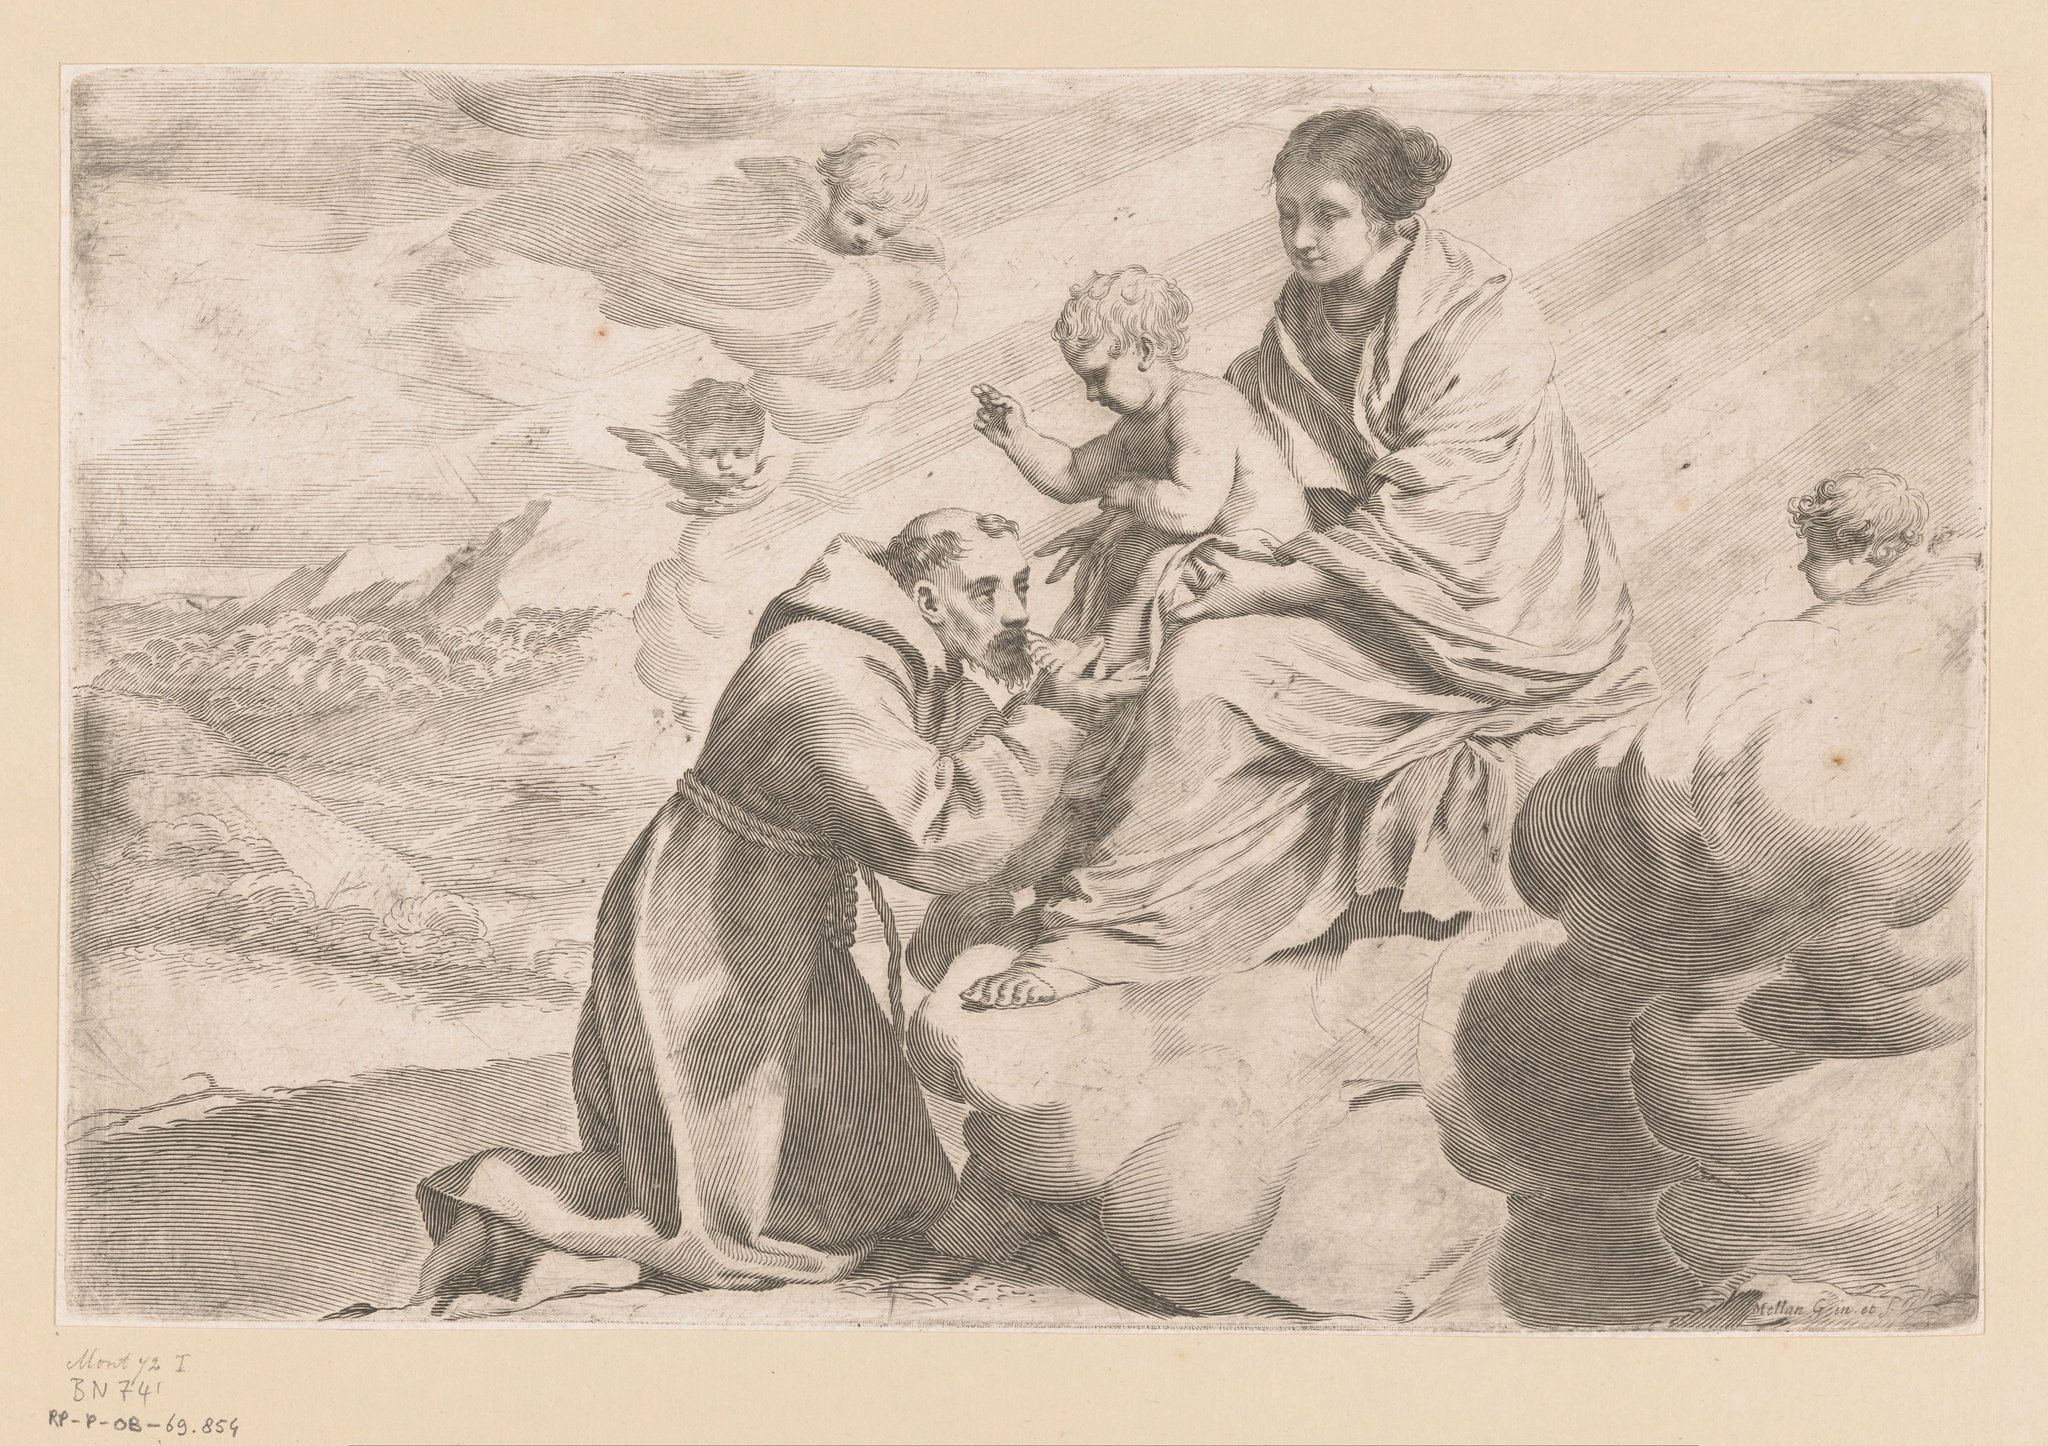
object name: print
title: H. Franciscus van Assisi geknield voor Maria met Kind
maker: claude mellan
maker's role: draughtsman, print maker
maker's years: 1598-1688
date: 1608-1688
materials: paper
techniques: engraving, intaglio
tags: madonna: i.e. mary with the christ-child, founder of the order of friars minor (franciscans), francis(cus) of assisi; possible attributes: book, crucifix, lily, skull, stigmata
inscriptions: collector's mark: Lugt 240